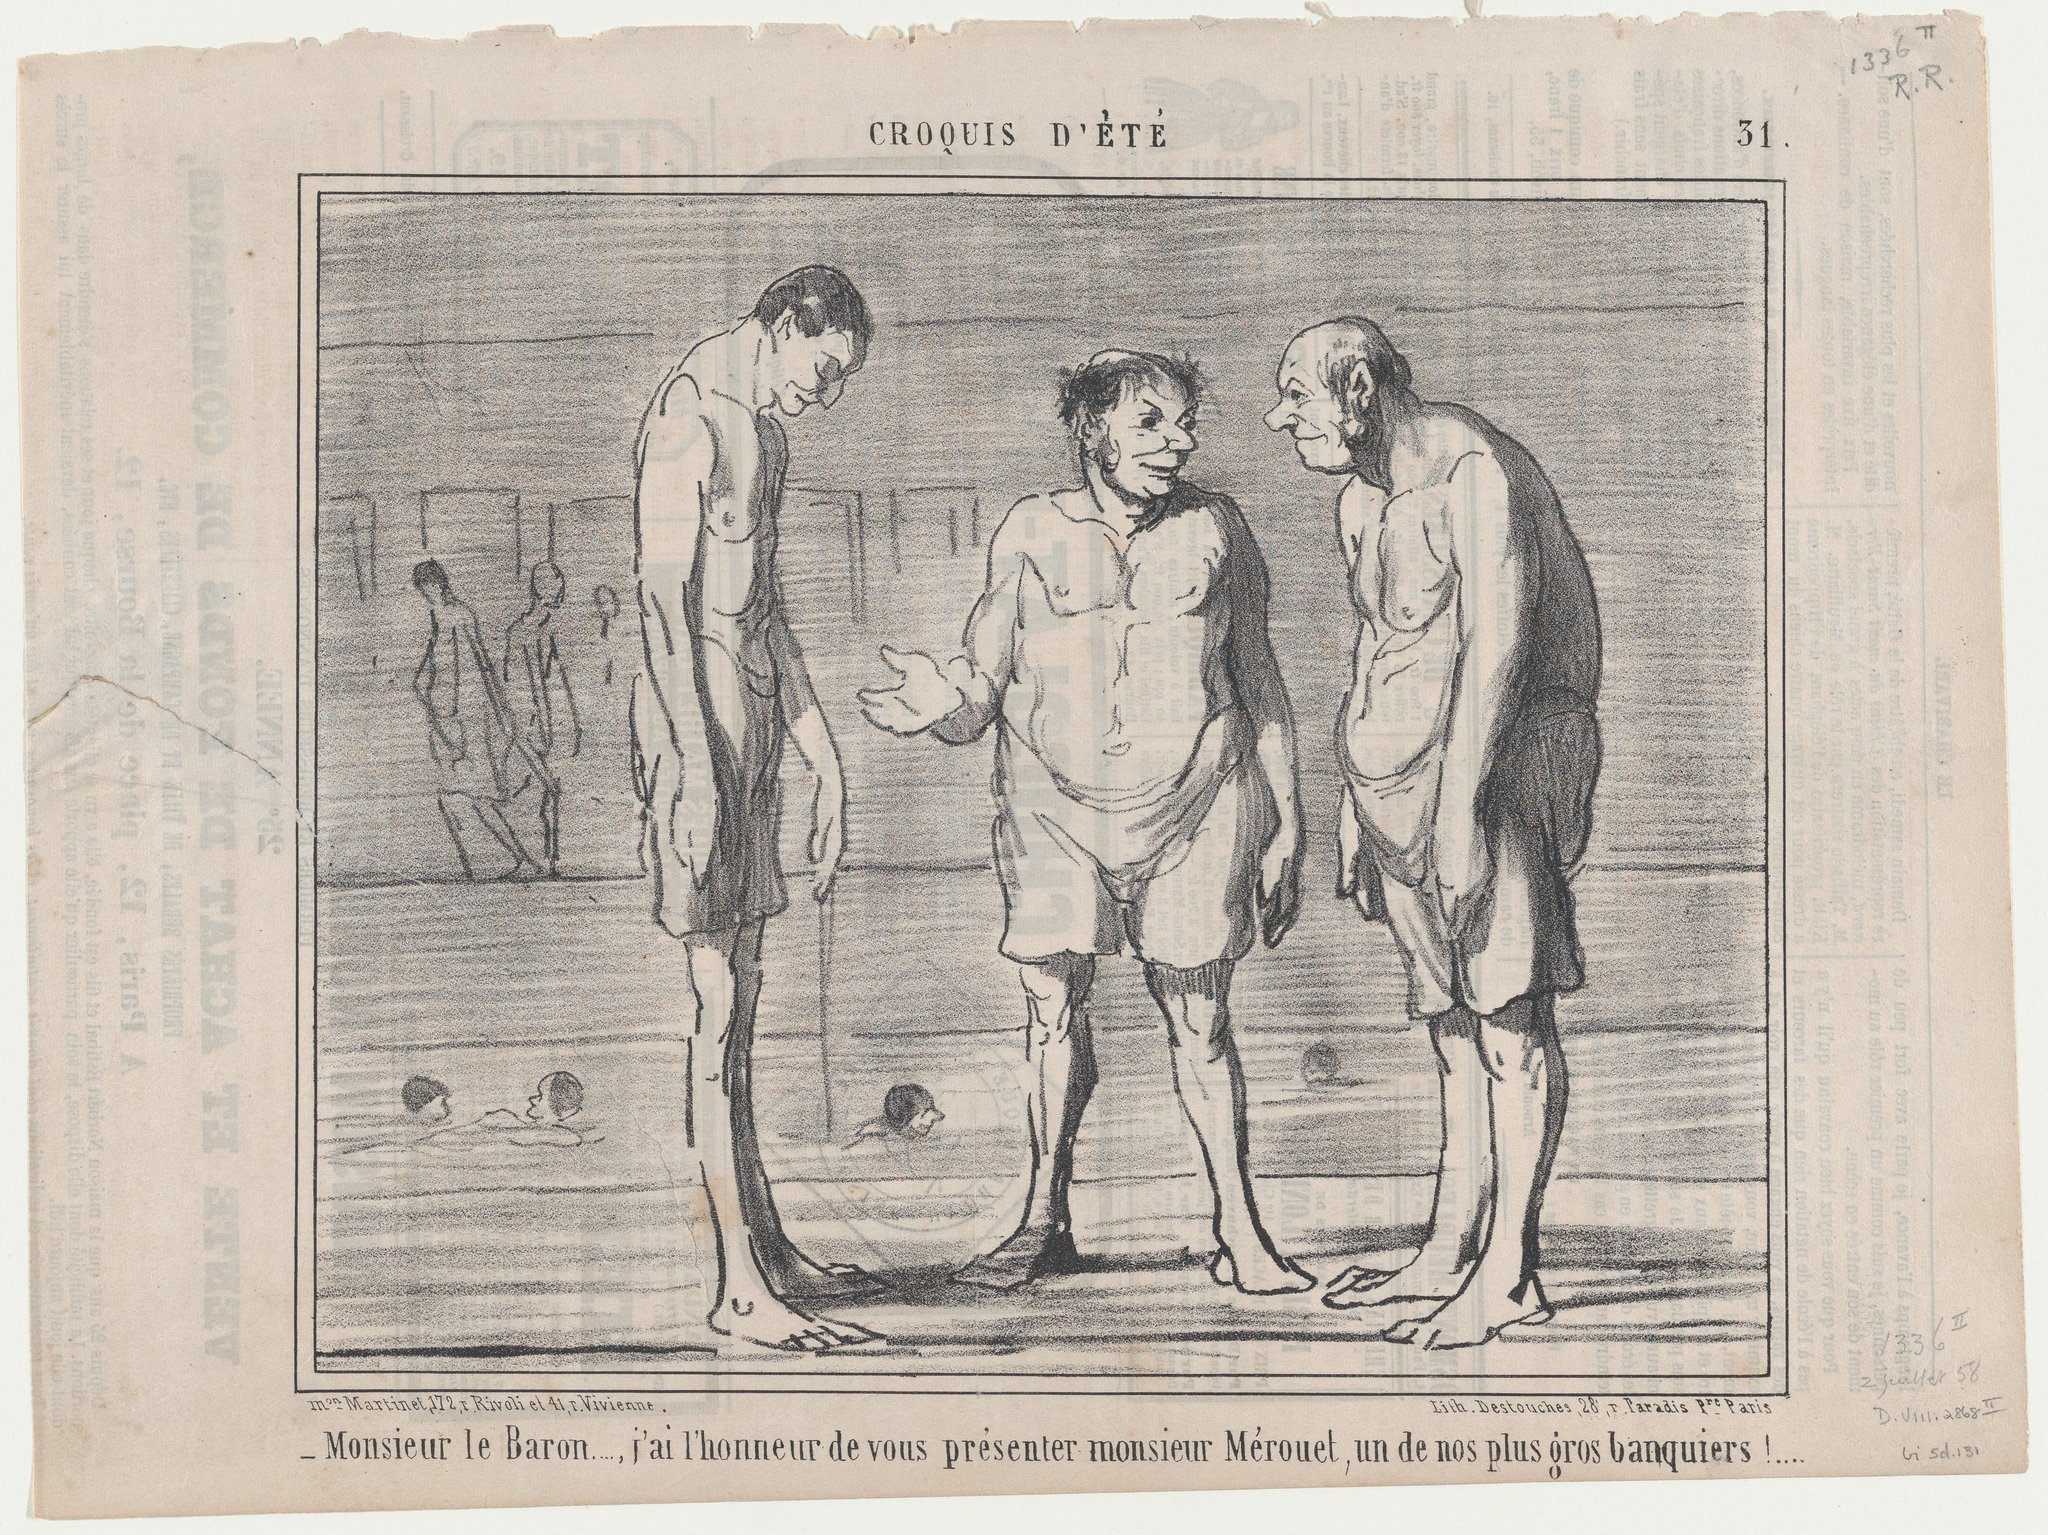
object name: print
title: Monsieur le Baron..., j'ai l'honneur..., from Croquis Été, published in Le Charivari, July 2, 1858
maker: honoré daumier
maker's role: artist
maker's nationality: french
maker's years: 1808-1879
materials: paper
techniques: lithograph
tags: men